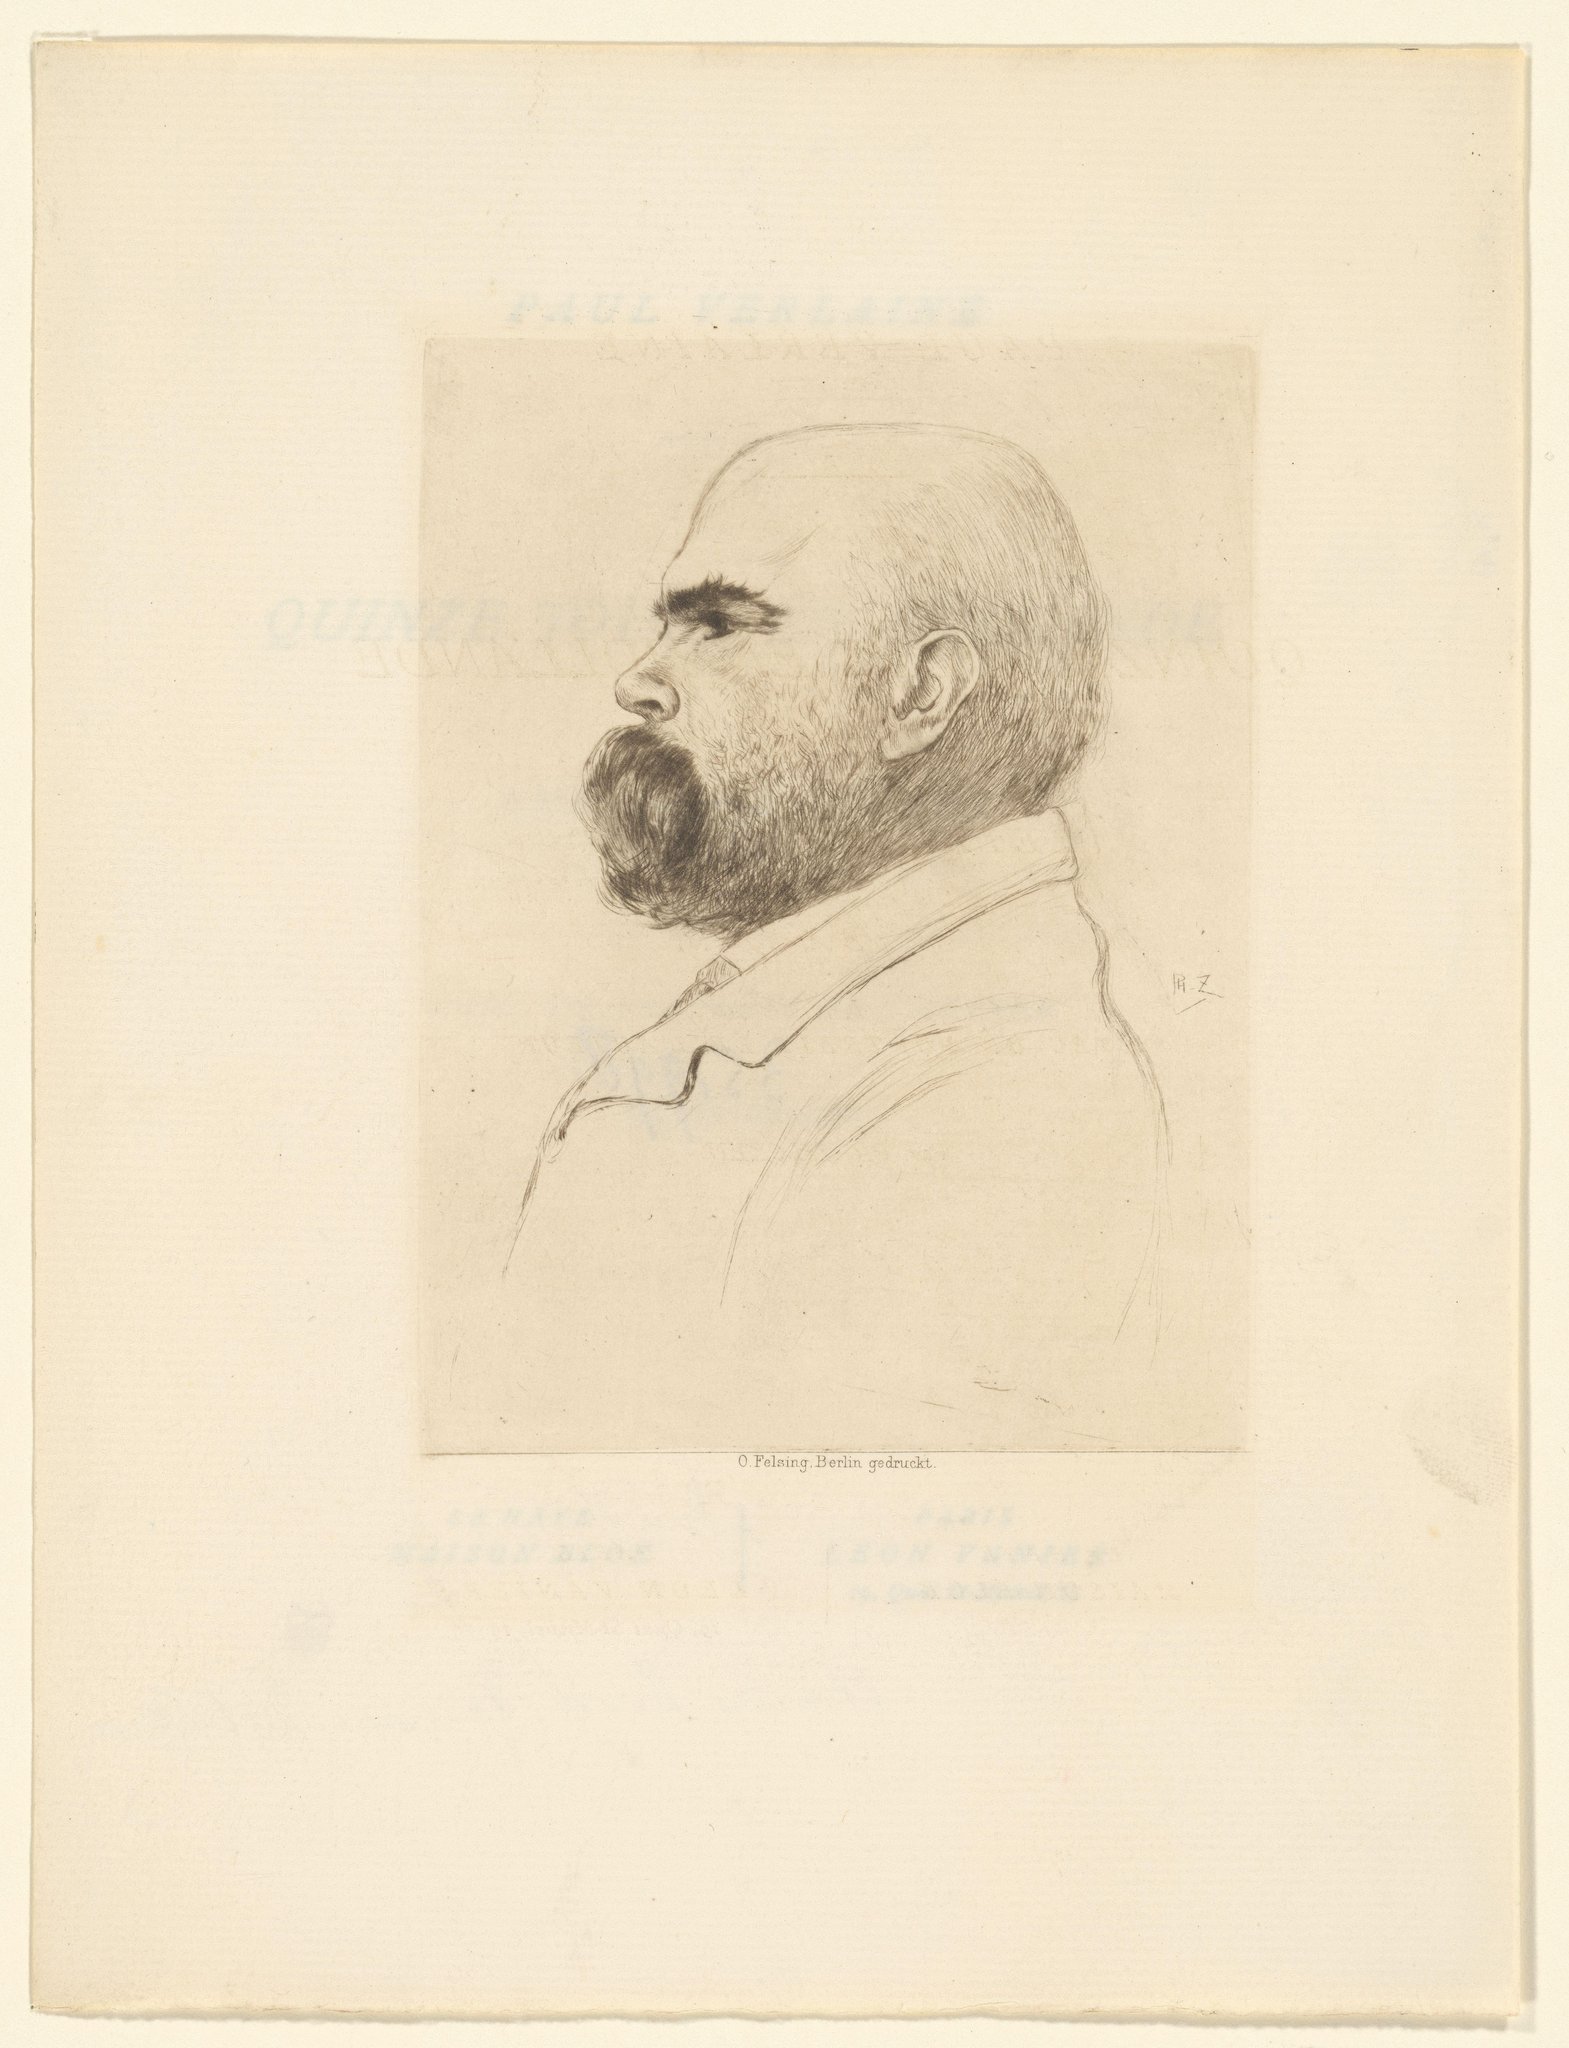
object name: book cover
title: Portret van Paul Verlaine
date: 1893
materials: paper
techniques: drypoint, intaglio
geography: berlin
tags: paris, paul verlaine, historical persons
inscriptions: collector's mark: Lugt 2760, collector's mark: Lugt 2228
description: Deze prent is gebruikt in: Verlaine, Paul. Quinze jours en Hollande. Den Haag: Maison Blok, 1893.